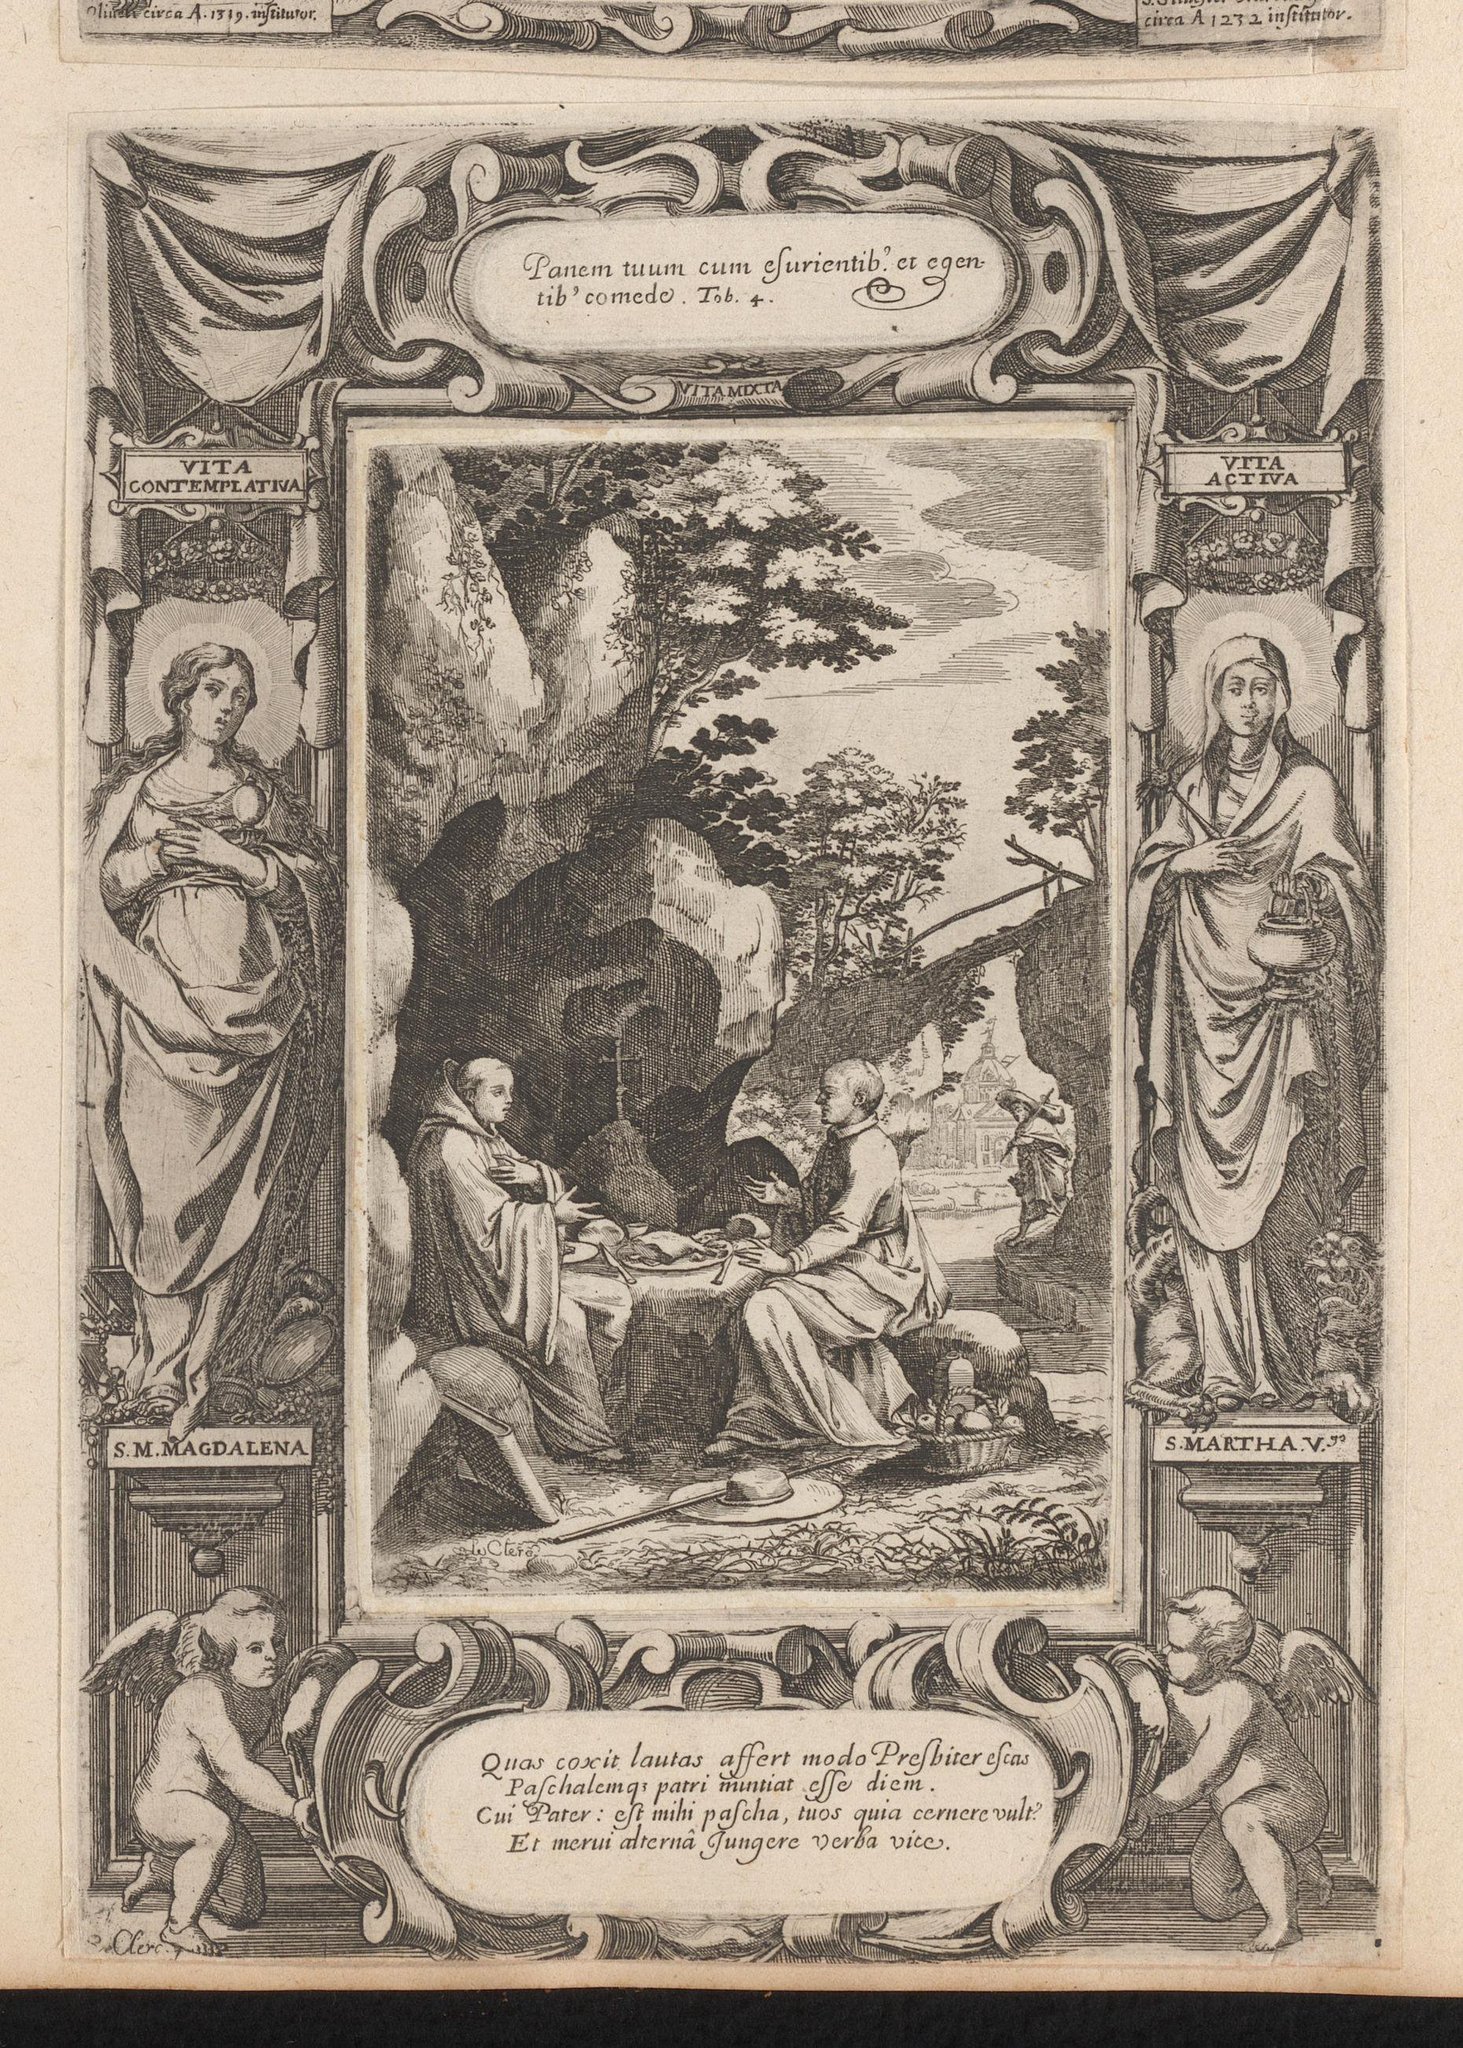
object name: print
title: Scènes uit het leven van H. Benedictus van Nursia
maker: sébastien leclerc (i)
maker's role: print maker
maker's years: 1637-1714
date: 1658-1659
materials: paper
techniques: etching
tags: benedict of nurcia, abbot of monte cassino and founder of the benedictine order; possible attributes: aspergillum, book, cup (sometimes broken), raven with loaf, sieve (or tray)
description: Maakt deel uit van een serie bestaande uit 33 prenten met voorstellingen uit het leven van de Heilige Benedictus van Nursia in ornamentele cartouches, uitgegeven in 1658-1659. De prenten zijn gedrukt van drie afzonderlijke platen bestaande uit de voorstelling, de cartouche en de tekst.